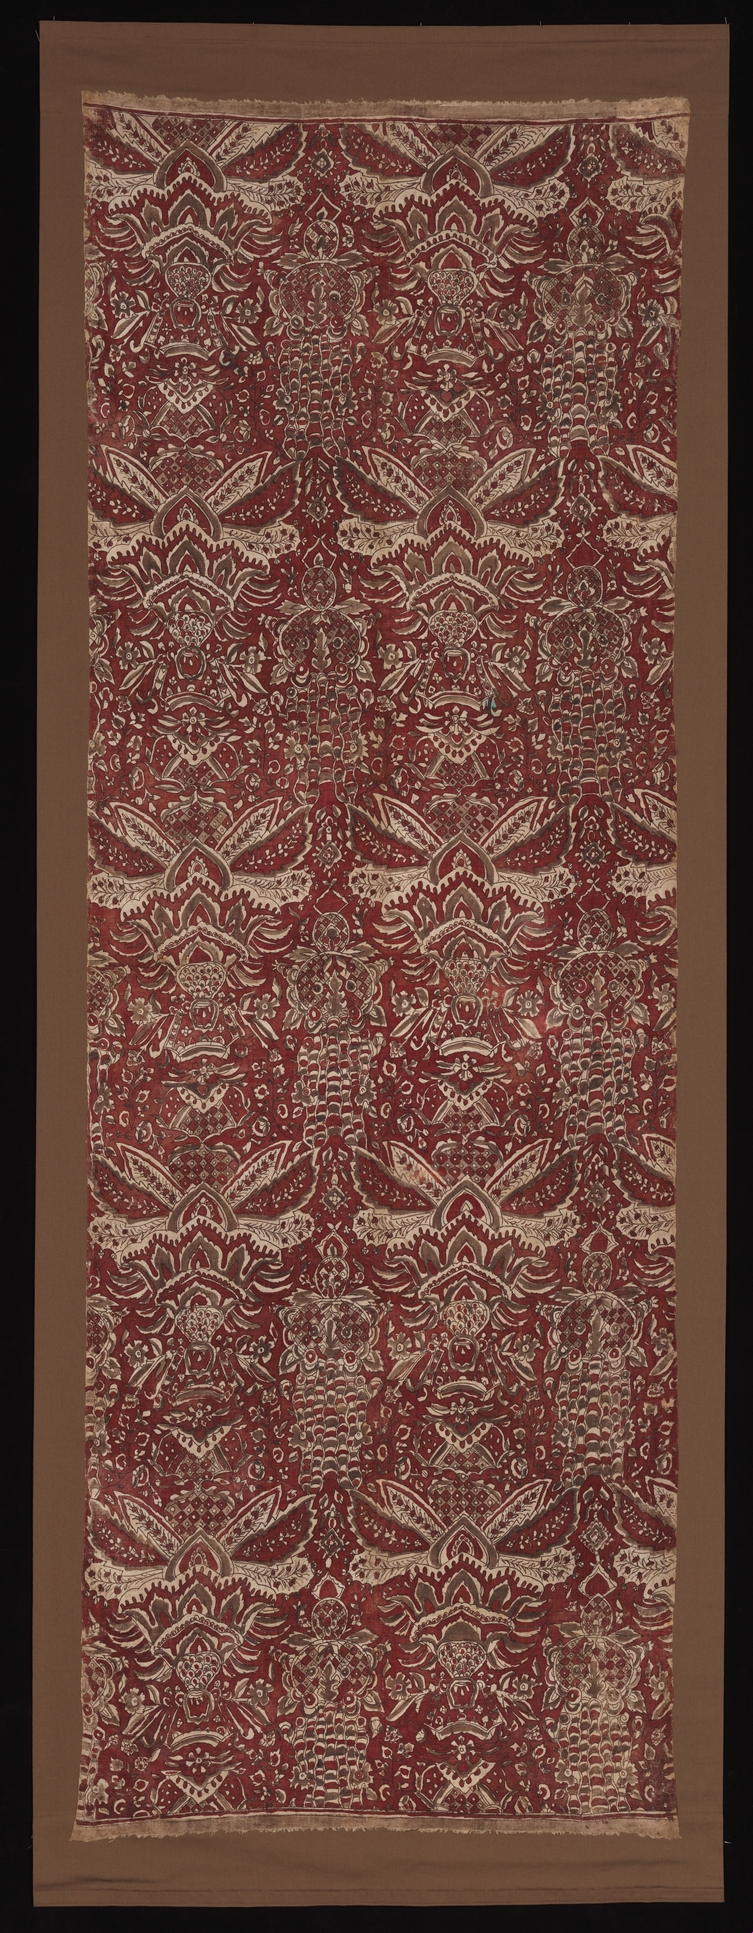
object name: ceremonial hanging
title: Long Cloth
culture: indian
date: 1720-1729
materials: cotton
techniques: dyeing, painting